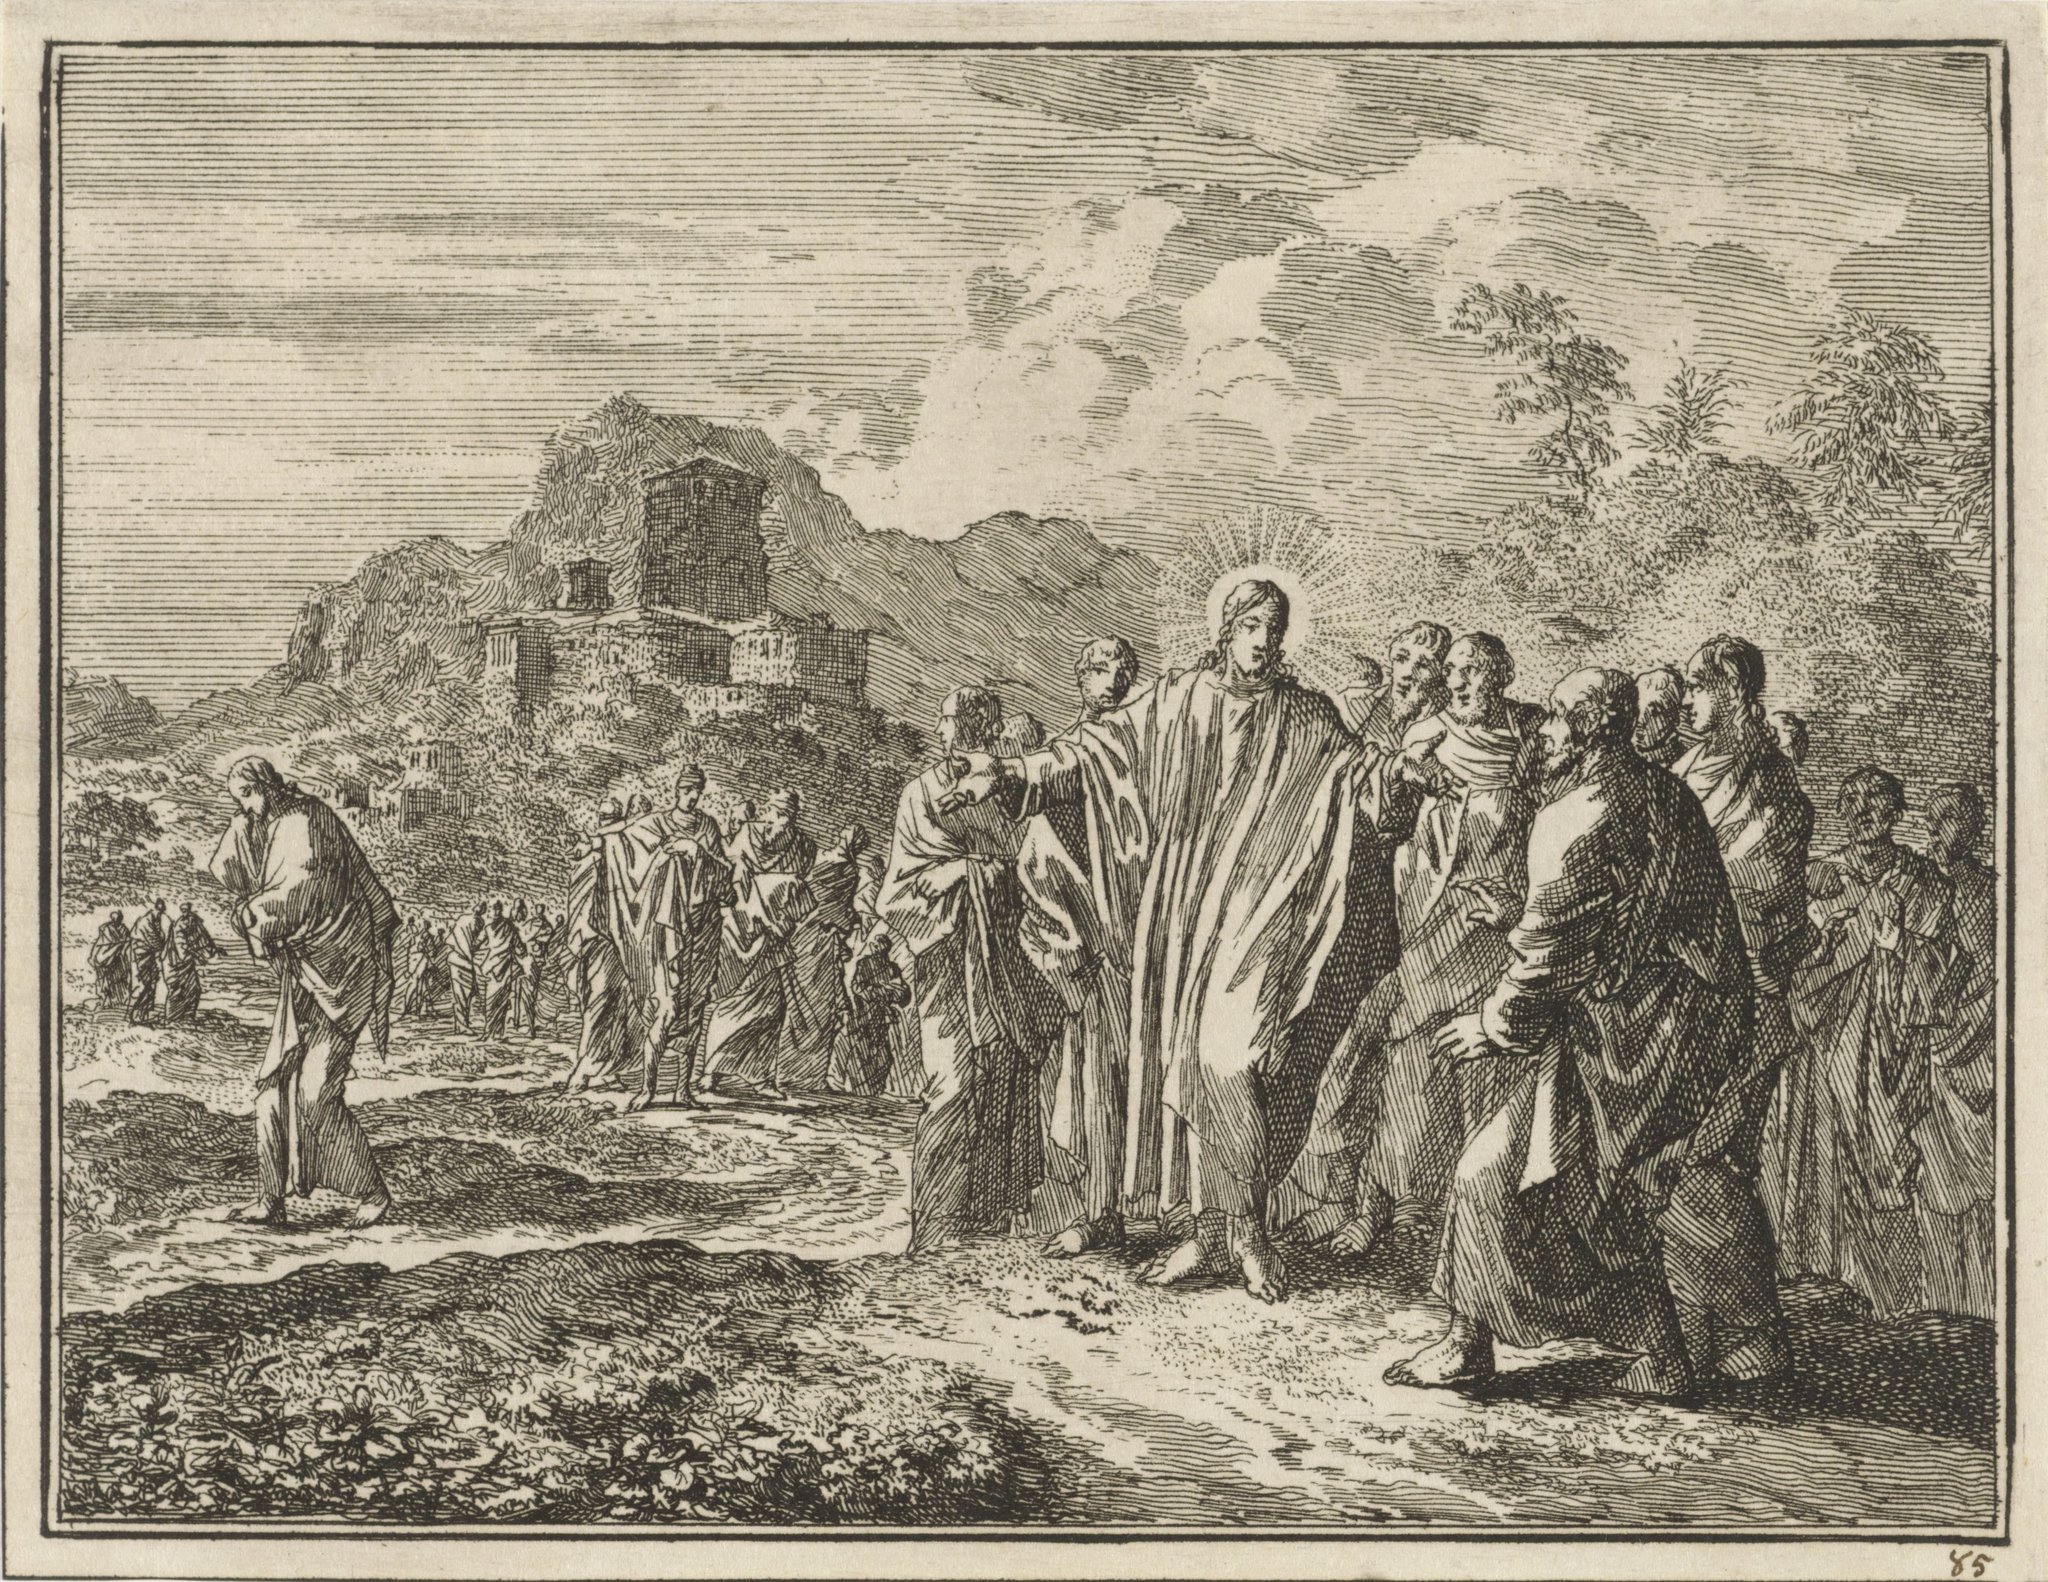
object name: print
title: Christus geeft raad aan een rijke jongeling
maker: jan luyken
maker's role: draughtsman, print maker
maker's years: 1649-1712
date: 1712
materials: paper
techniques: etching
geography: amsterdam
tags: a rich young man who came to see christ goes away sorrowful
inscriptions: number: ‘85’, collector's mark: Lugt 2228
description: Proefdruk van illustratie uit: Luyken, Jan. De schriftuurlyke geschiedenissen en gelykenissen van het Oude en Nieuwe Verbond, 2 delen. Amsterdam: Wed. Pieter Arentsz II en Cornelis van der Sys, 1712, dl. II.